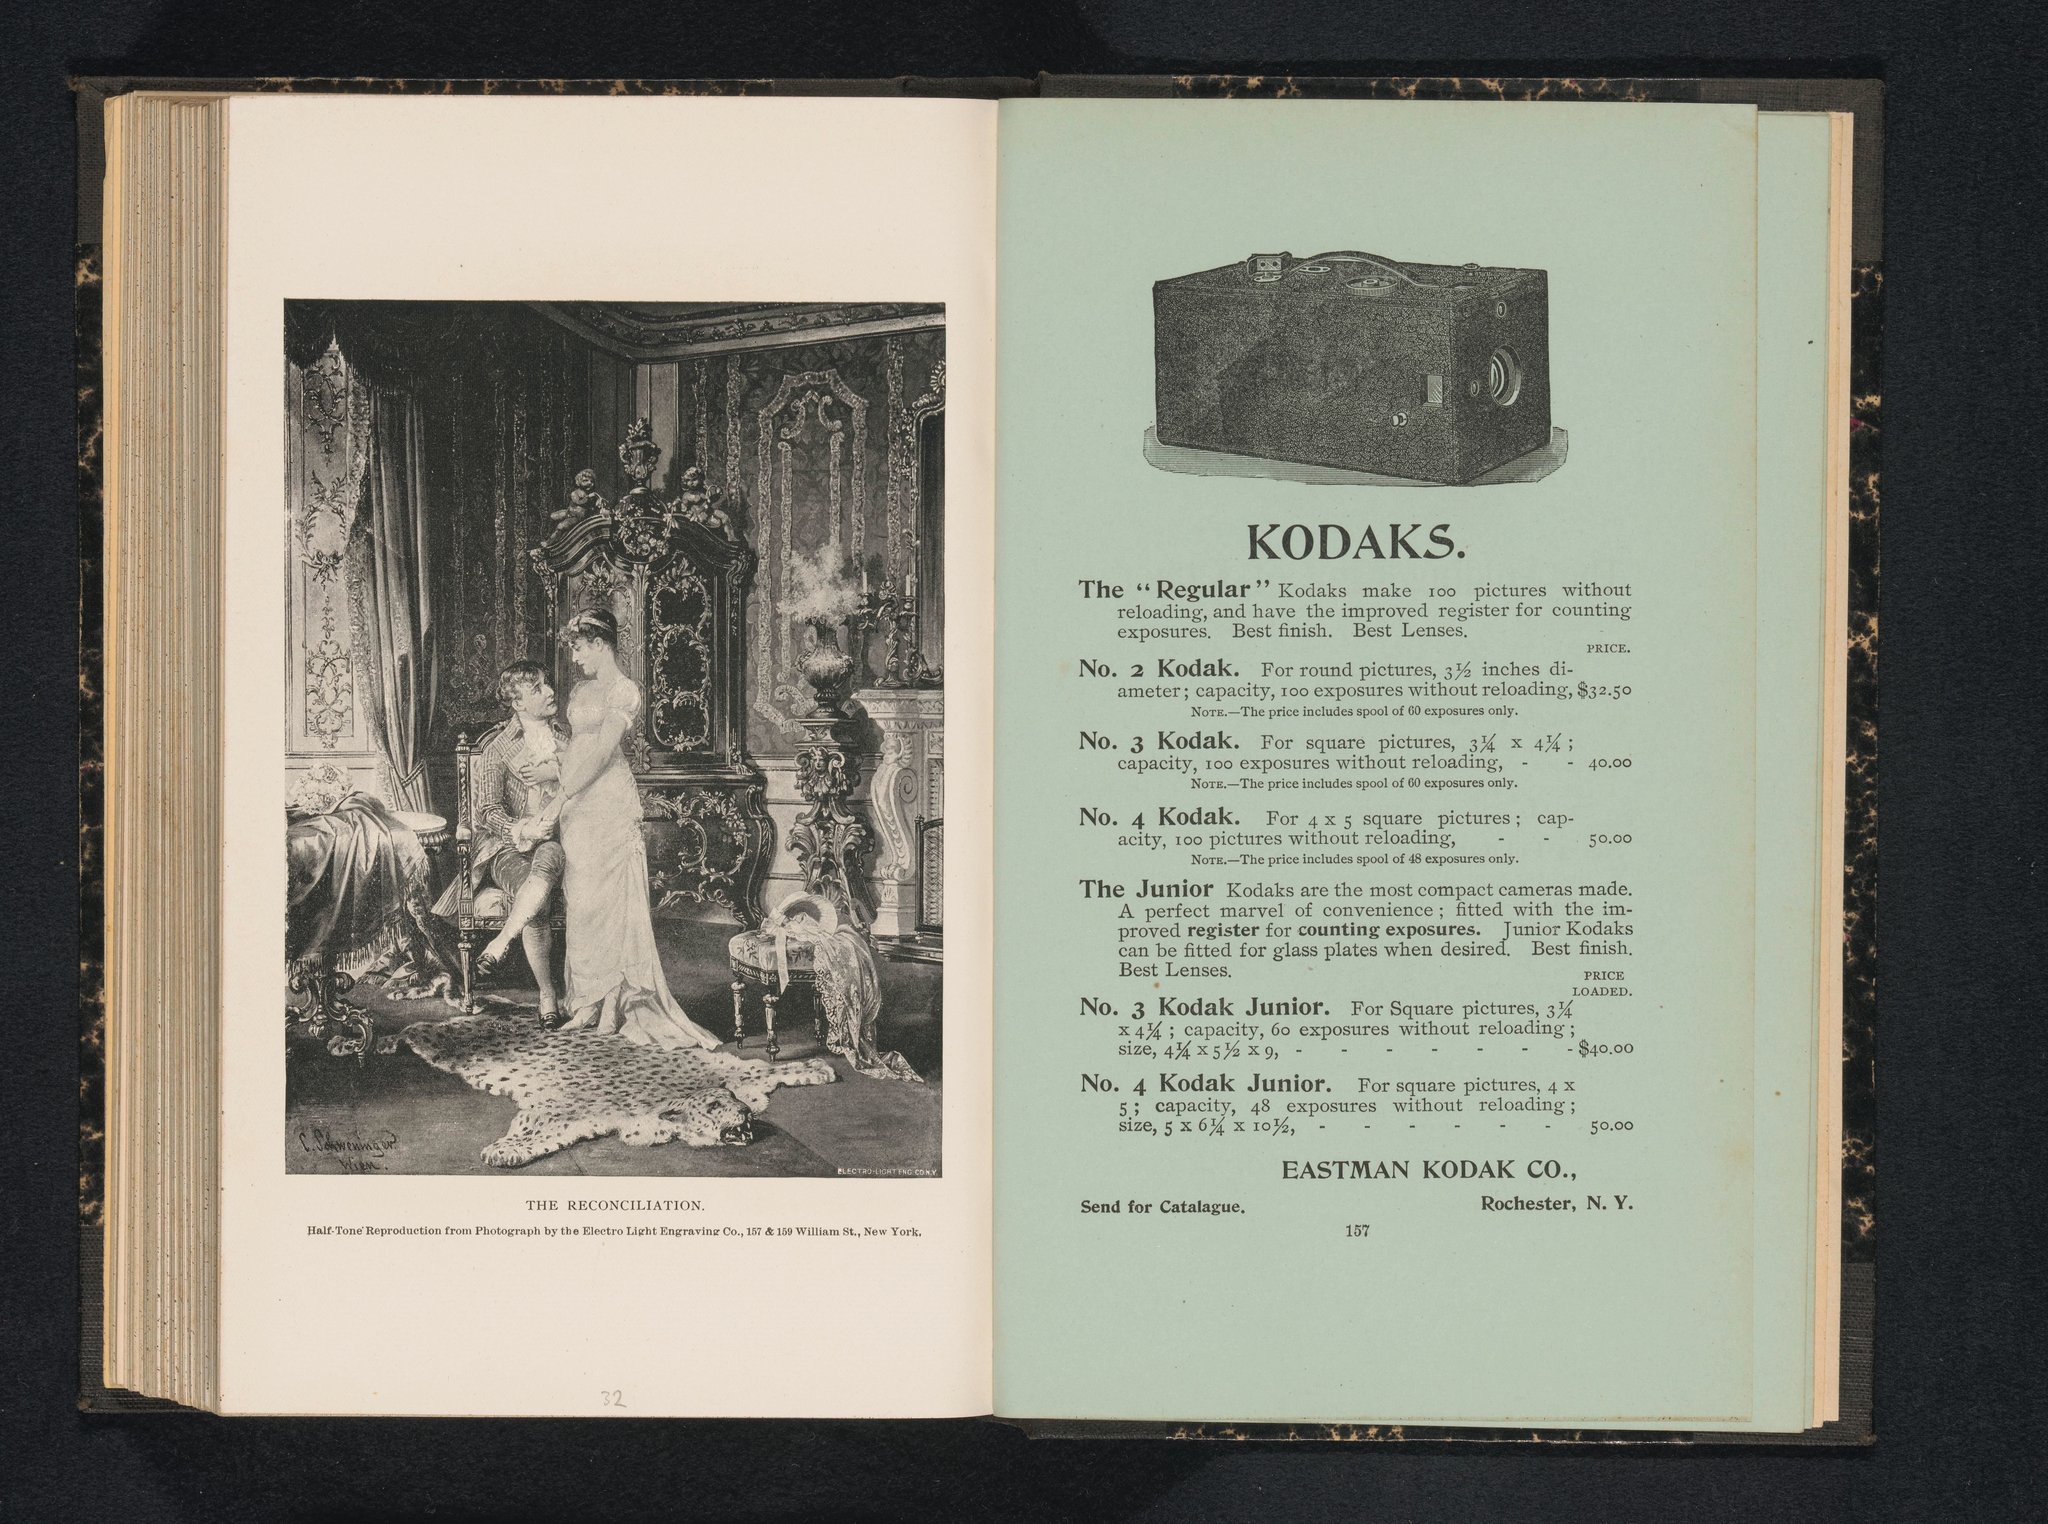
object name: page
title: Reproductie van een schilderij van verzoening door Carl Schweninger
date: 1887-1907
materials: paper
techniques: autotype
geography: new york city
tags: carpet, rug, interior of the house, couple of lovers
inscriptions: inscription: ‘Half-Tone reproduction from photograph by the Electro Light Engraving Co., 157 & 159 William St., New York’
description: Prent tegenover pagina 157 van de advertenties.